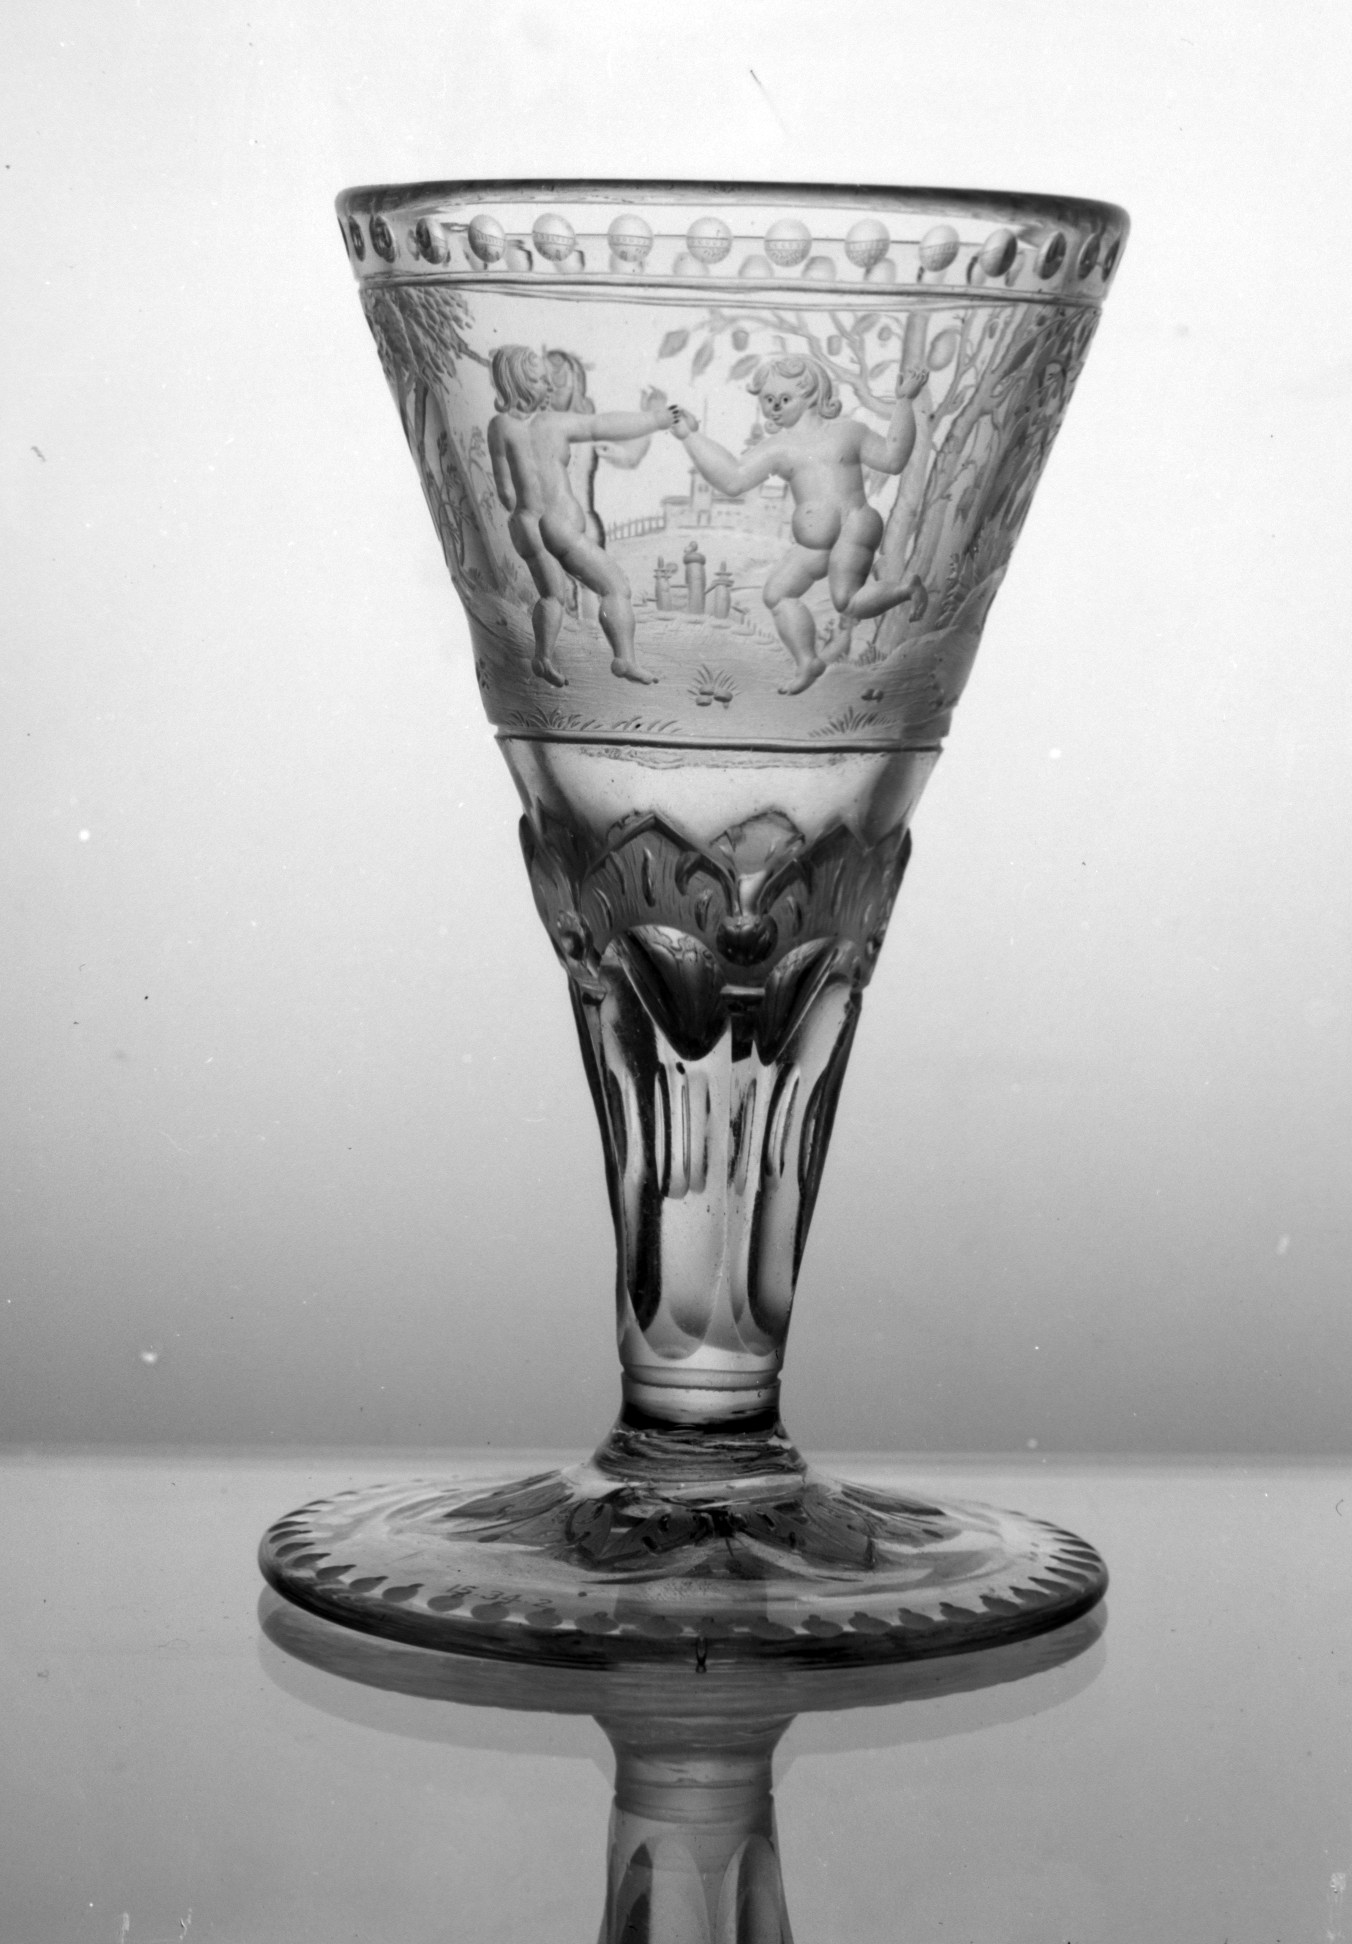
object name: wineglass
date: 1701-1800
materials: glass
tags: female nudes,trees